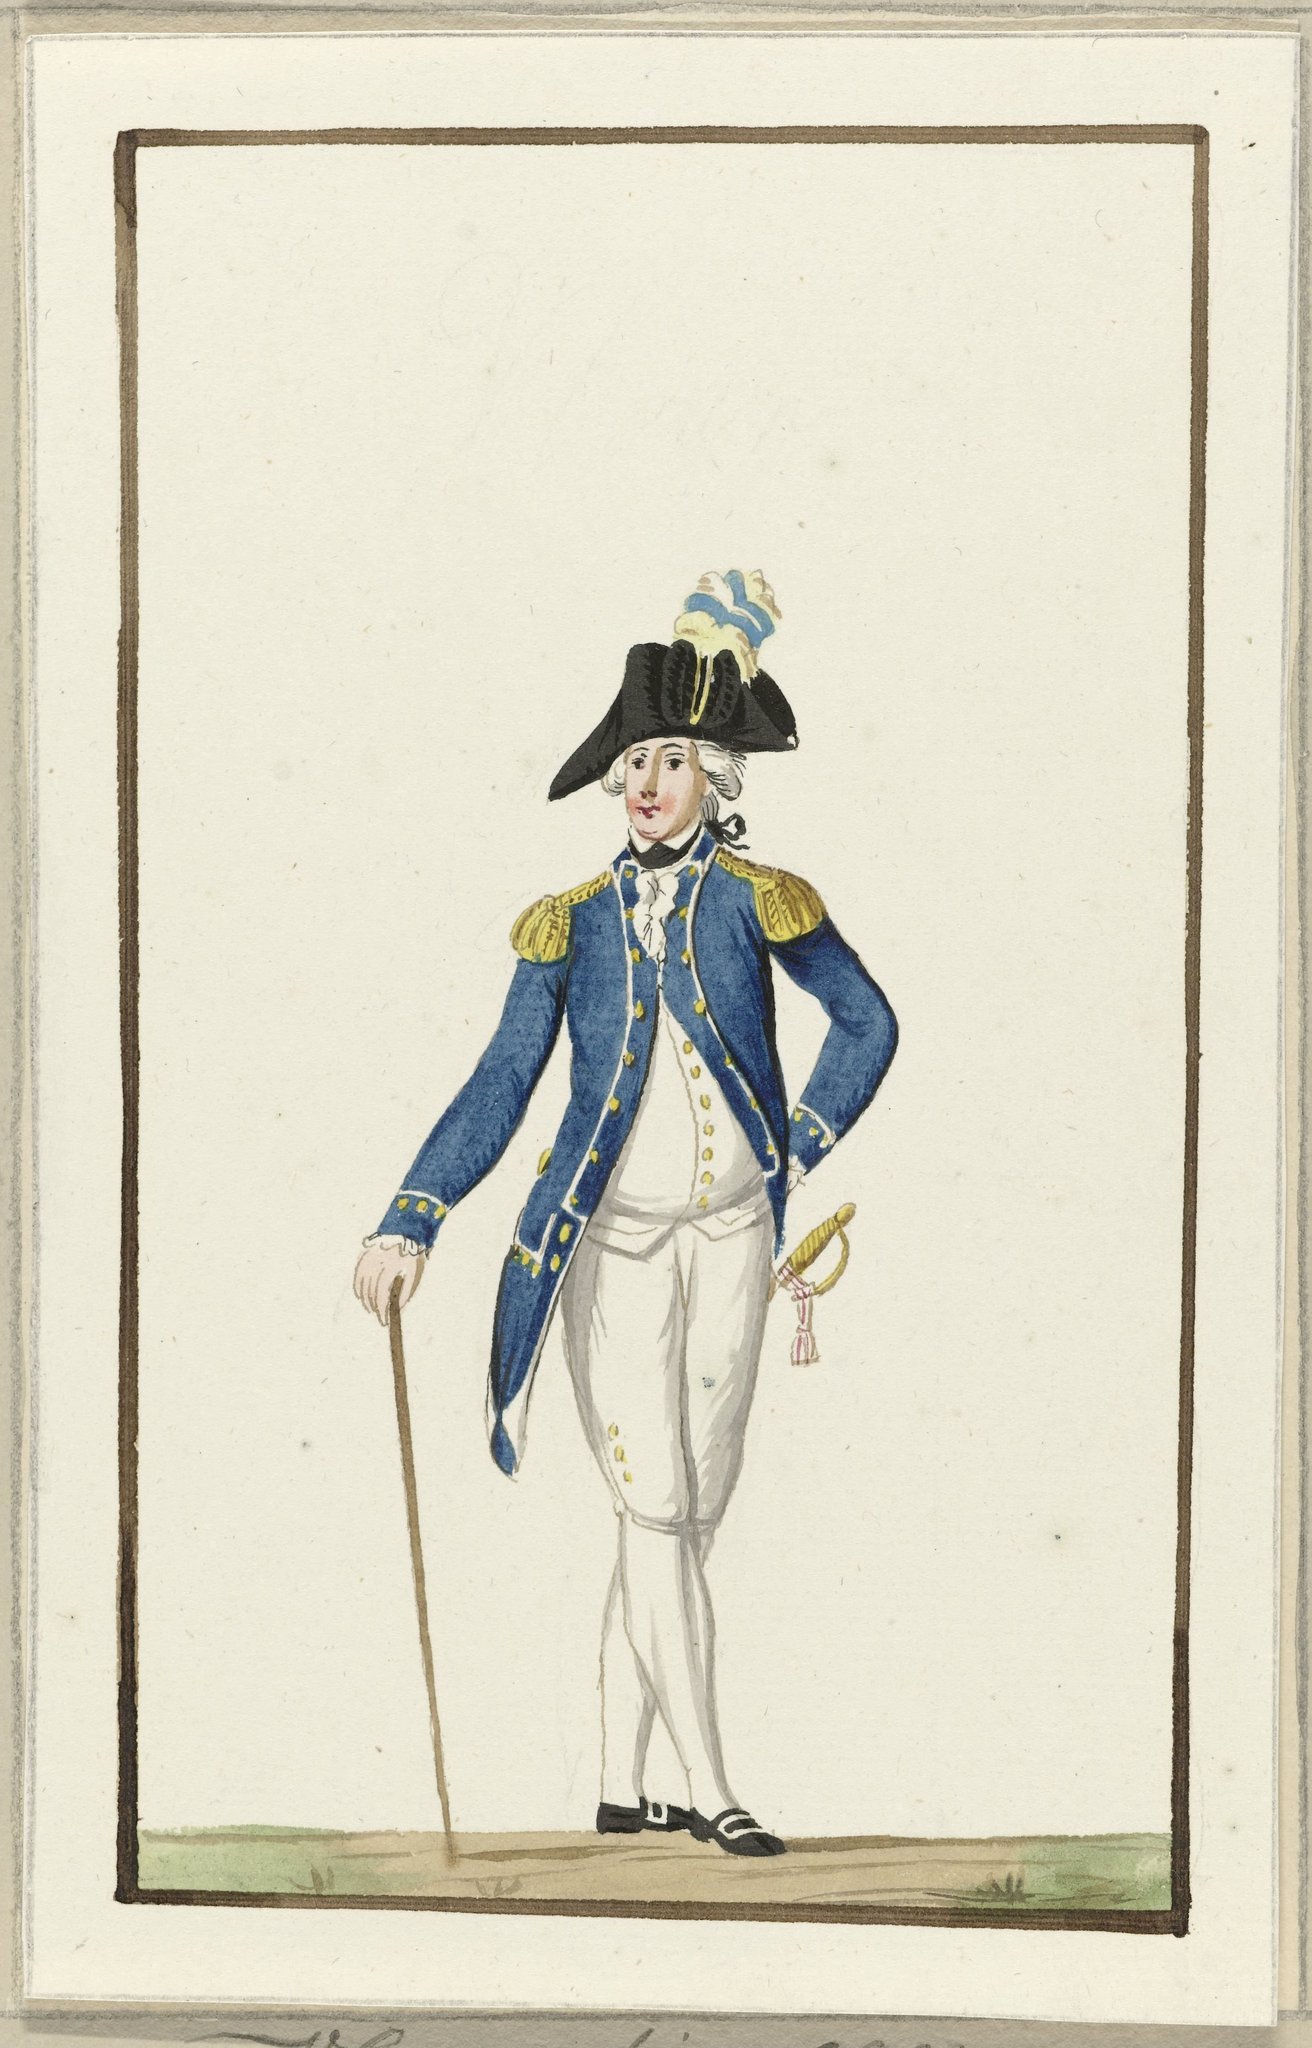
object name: drawing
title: Monteringen van 32 patriotse schutterijen en vrijkorpsen, ca. 1787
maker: Anonymous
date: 1787-1790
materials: paper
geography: northern netherlands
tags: (military) uniforms (+ citizen soldiery, civil guard, citizen militia), patriots (1780-1795)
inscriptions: collector's mark: Lugt 2228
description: Uniform van de schutterij van Vlaardingen. Onderdeel van een serie van 32 tekeningen van de verschillende monteringen (uniformen) van patriotse schutterijen en burgerkorpsen in Nederland in 1787.